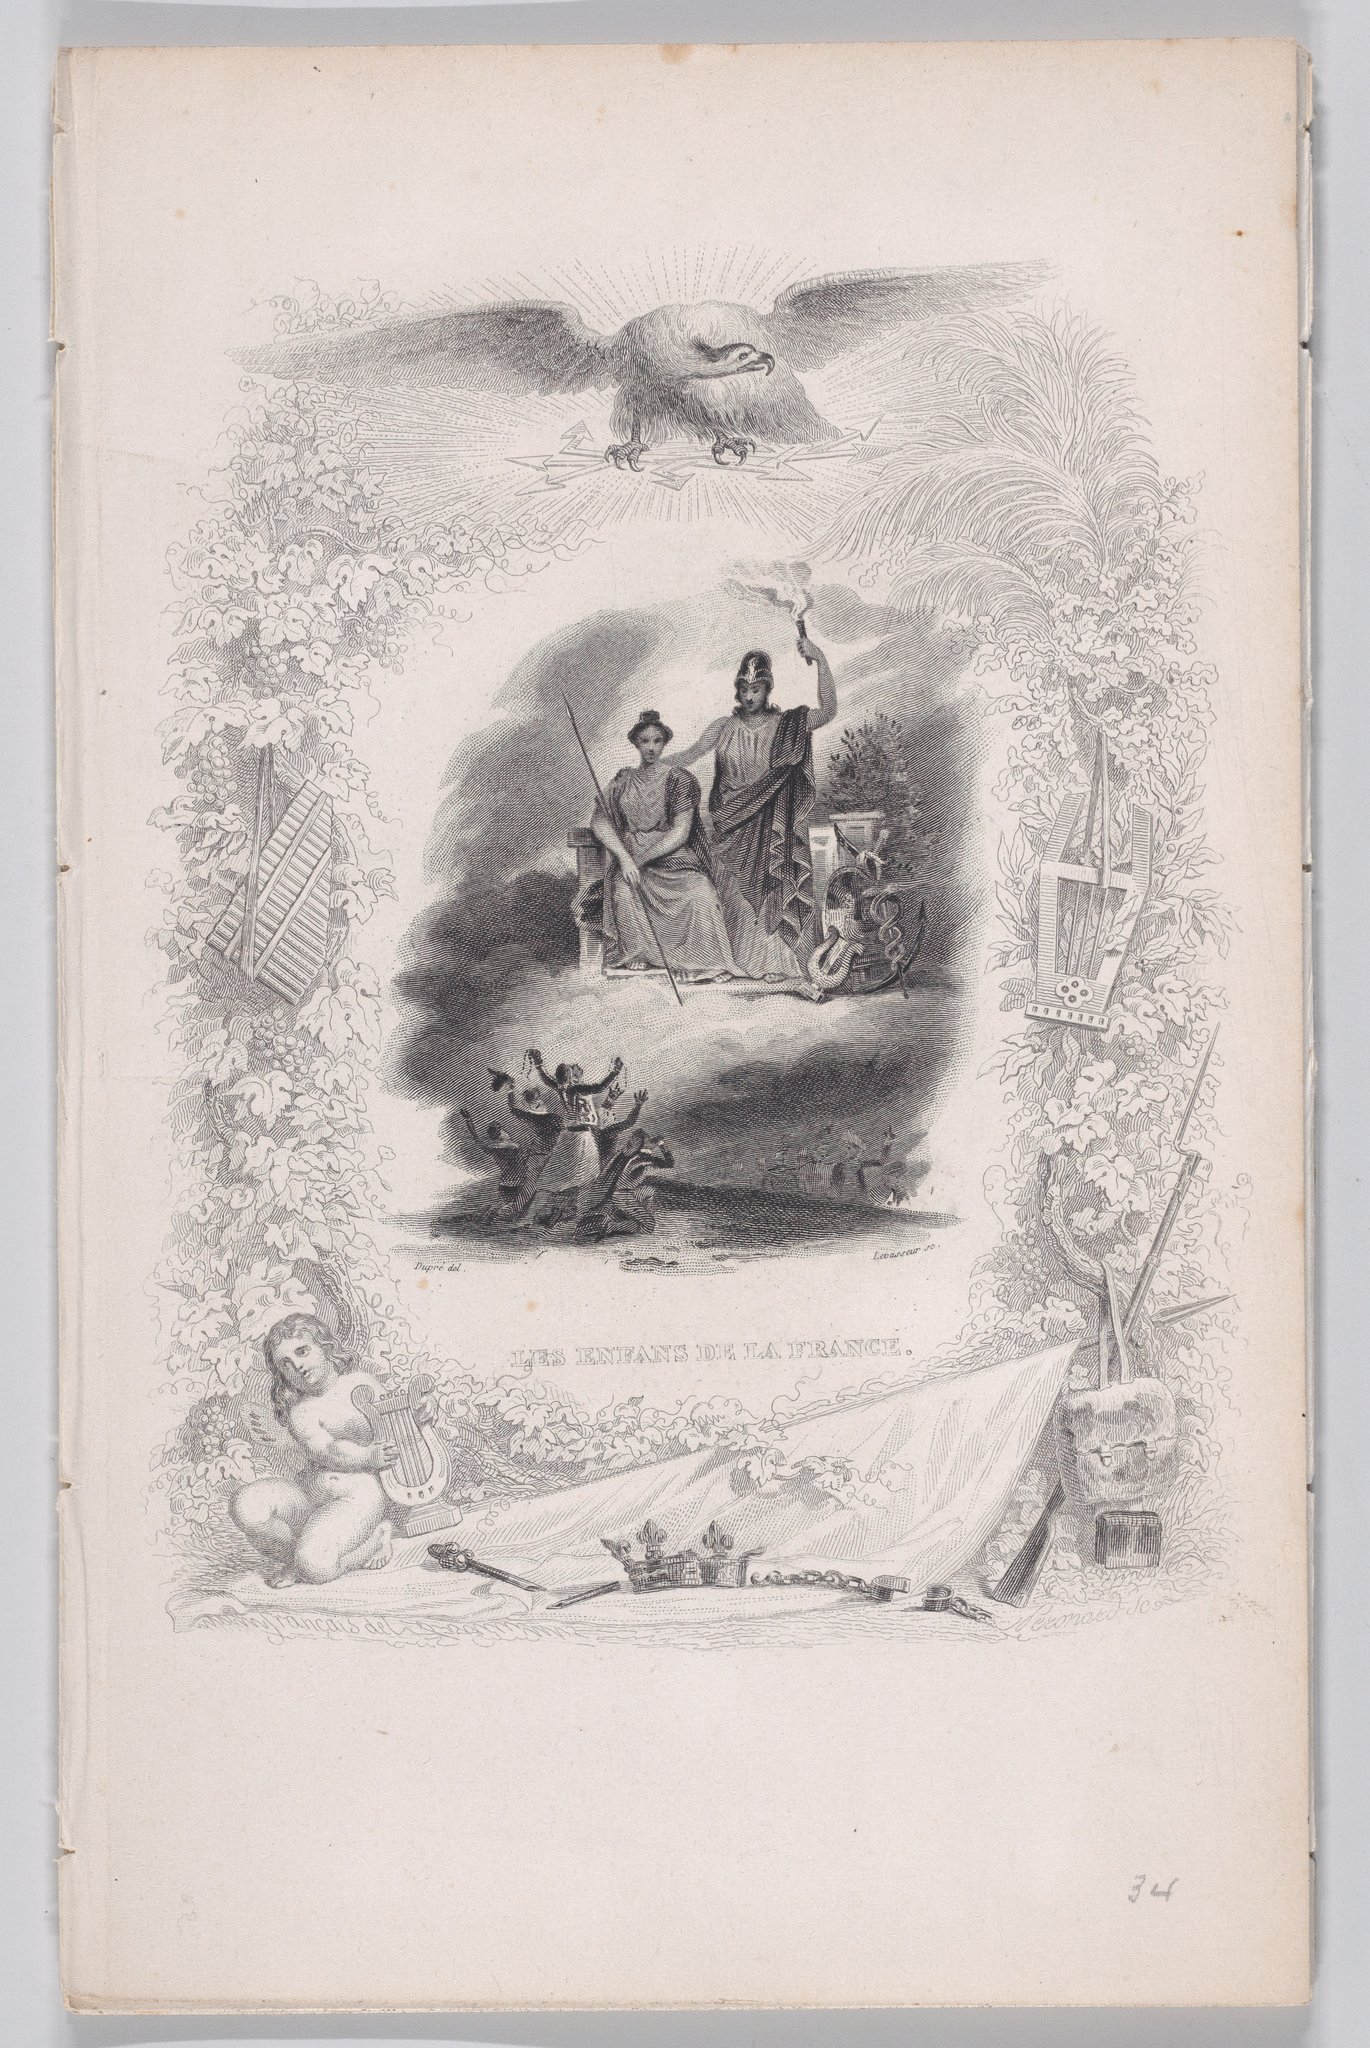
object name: print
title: The Children of France, from "The Complete Works of Béranger"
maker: alexandre-gustave-adolphe levasseur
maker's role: engraver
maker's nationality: french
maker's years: 19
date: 1829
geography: paris